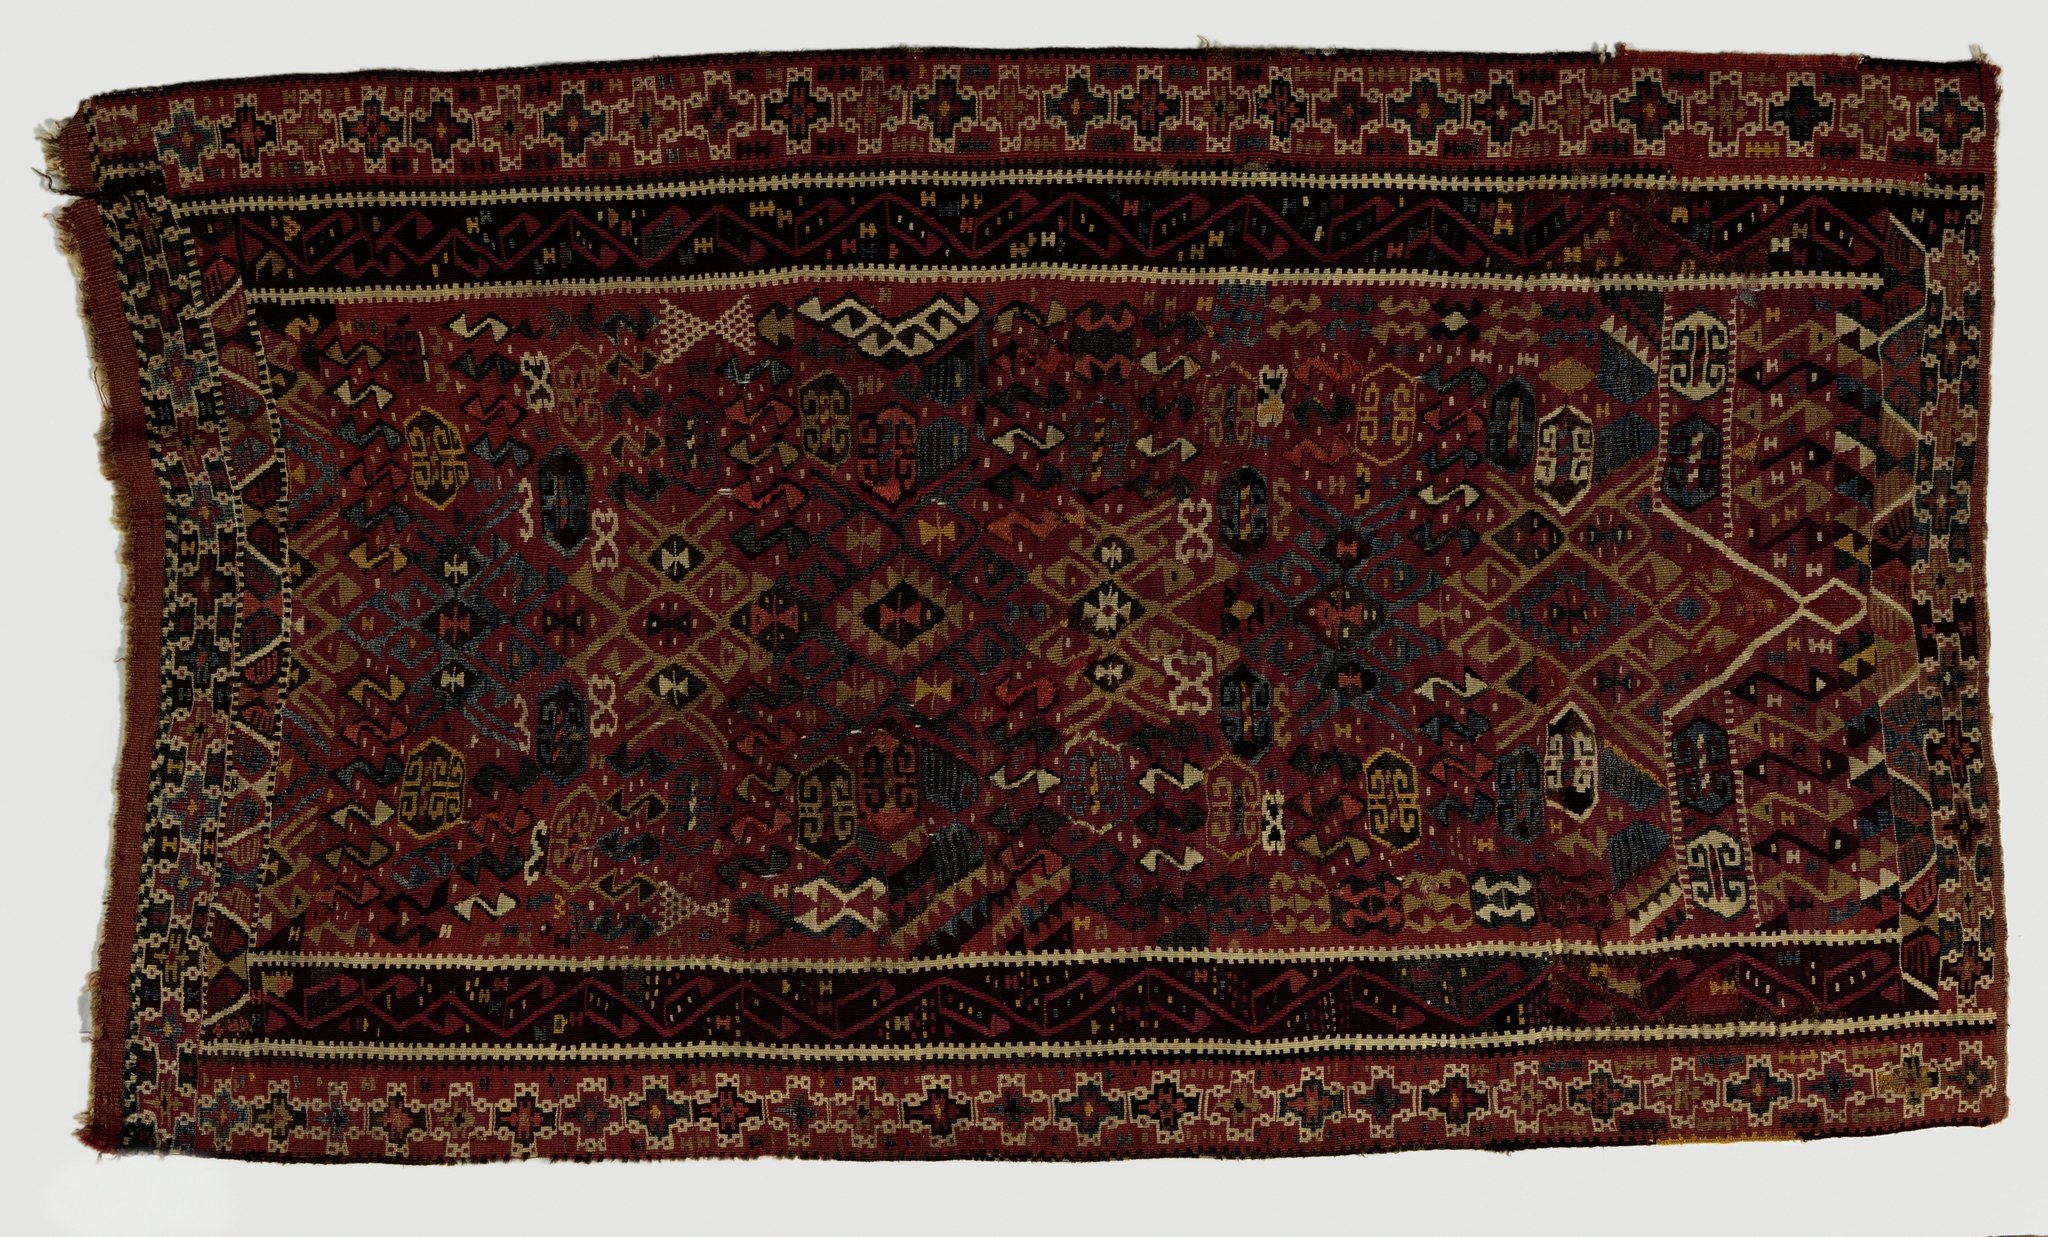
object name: oriental rug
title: Oosters tapijt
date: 1900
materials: wool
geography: asia minor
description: Bidkleed in kelim-techniek. Op het middenveld een kardinaalspaarse mihrab. Op de middenas staan afwisselend gekruiste ranken. Hiernaast liggende zeshoeken. Verder rijen s-sen.